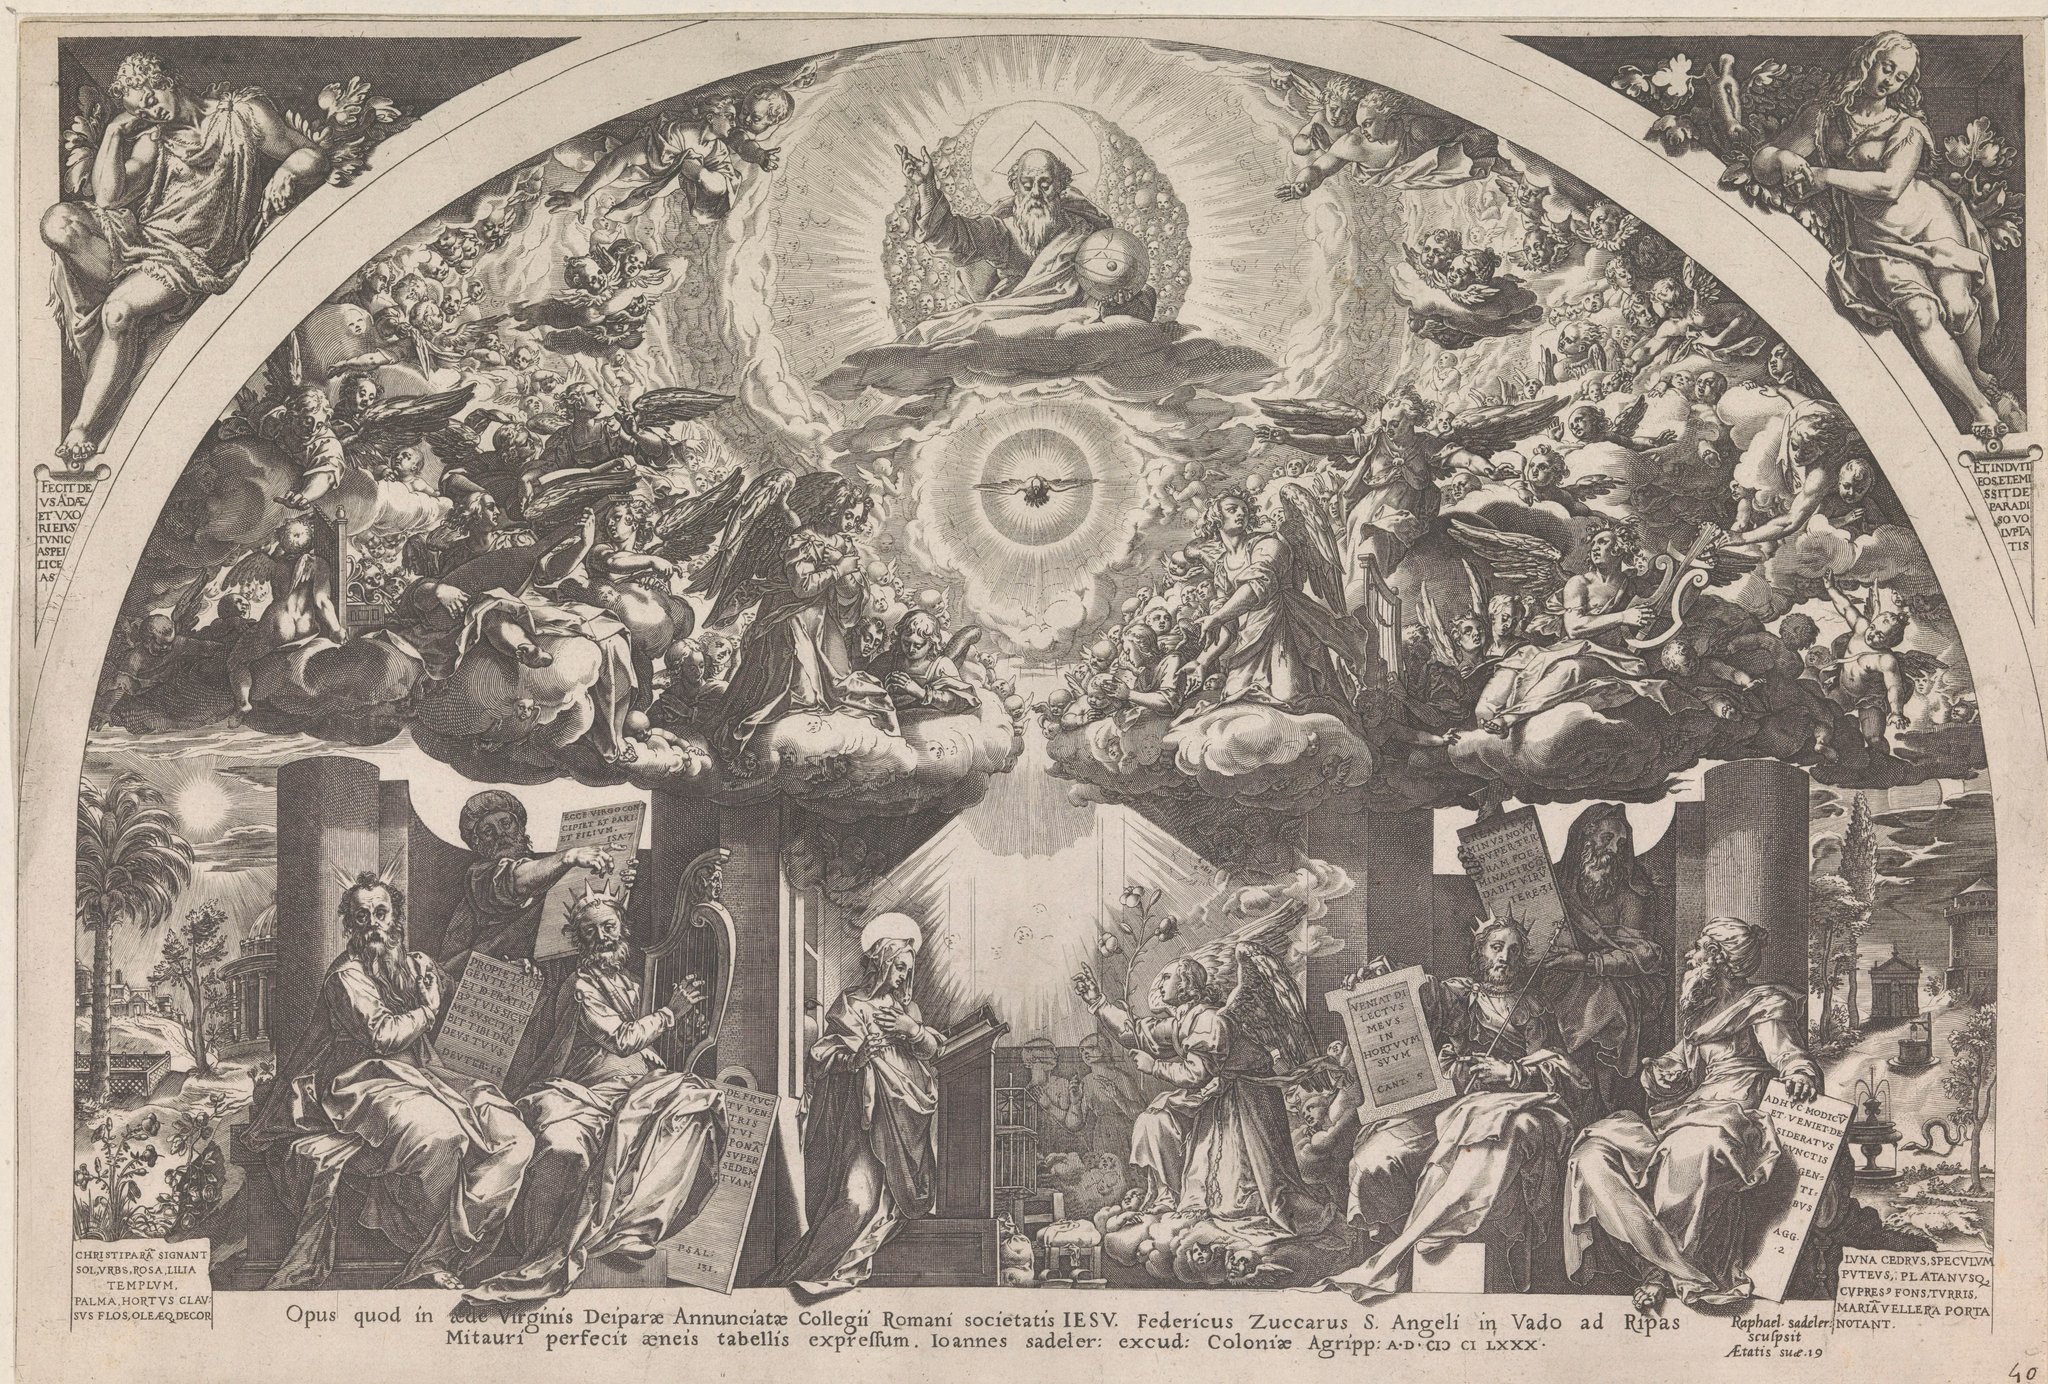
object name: print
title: Annunciatie met de zes profeten en engelenkoren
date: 1580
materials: paper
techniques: engraving, etching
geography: cologne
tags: adam and eve (not in biblical context), groups of prophets, usually holding books or scrolls (isaiah, jeremiah, ezekiel, daniel, hosea, joel, amos, obadiah, jonah, micah, nahum, habakkuk, zephaniah, haggai, zechariah, malachi), the annunciation: mary, usually reading, is visited by the angel (sometimes a woman overhears the conversation), angels, god the father (as bearded old man) enthroned, usually with crown or tiara, and with sceptre and/or globe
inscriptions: number: ‘40’, collector's mark: Lugt 2228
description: De maagd Maria wordt bezocht door de engel Gabriël. Hij verkondigt haar de geboorte van een zoon die Christus zal heten. Boven in de hemel God de Vader en de duif als symbool voor de Heilige Geest, omringd door de engelenkoren. Aan weerszijden van de annunciatievoorstelling drie profeten van het Oude Testament. Bovenaan links Adam, bovenaan rechts Eva. De prent heeft een Latijns onderschrift.